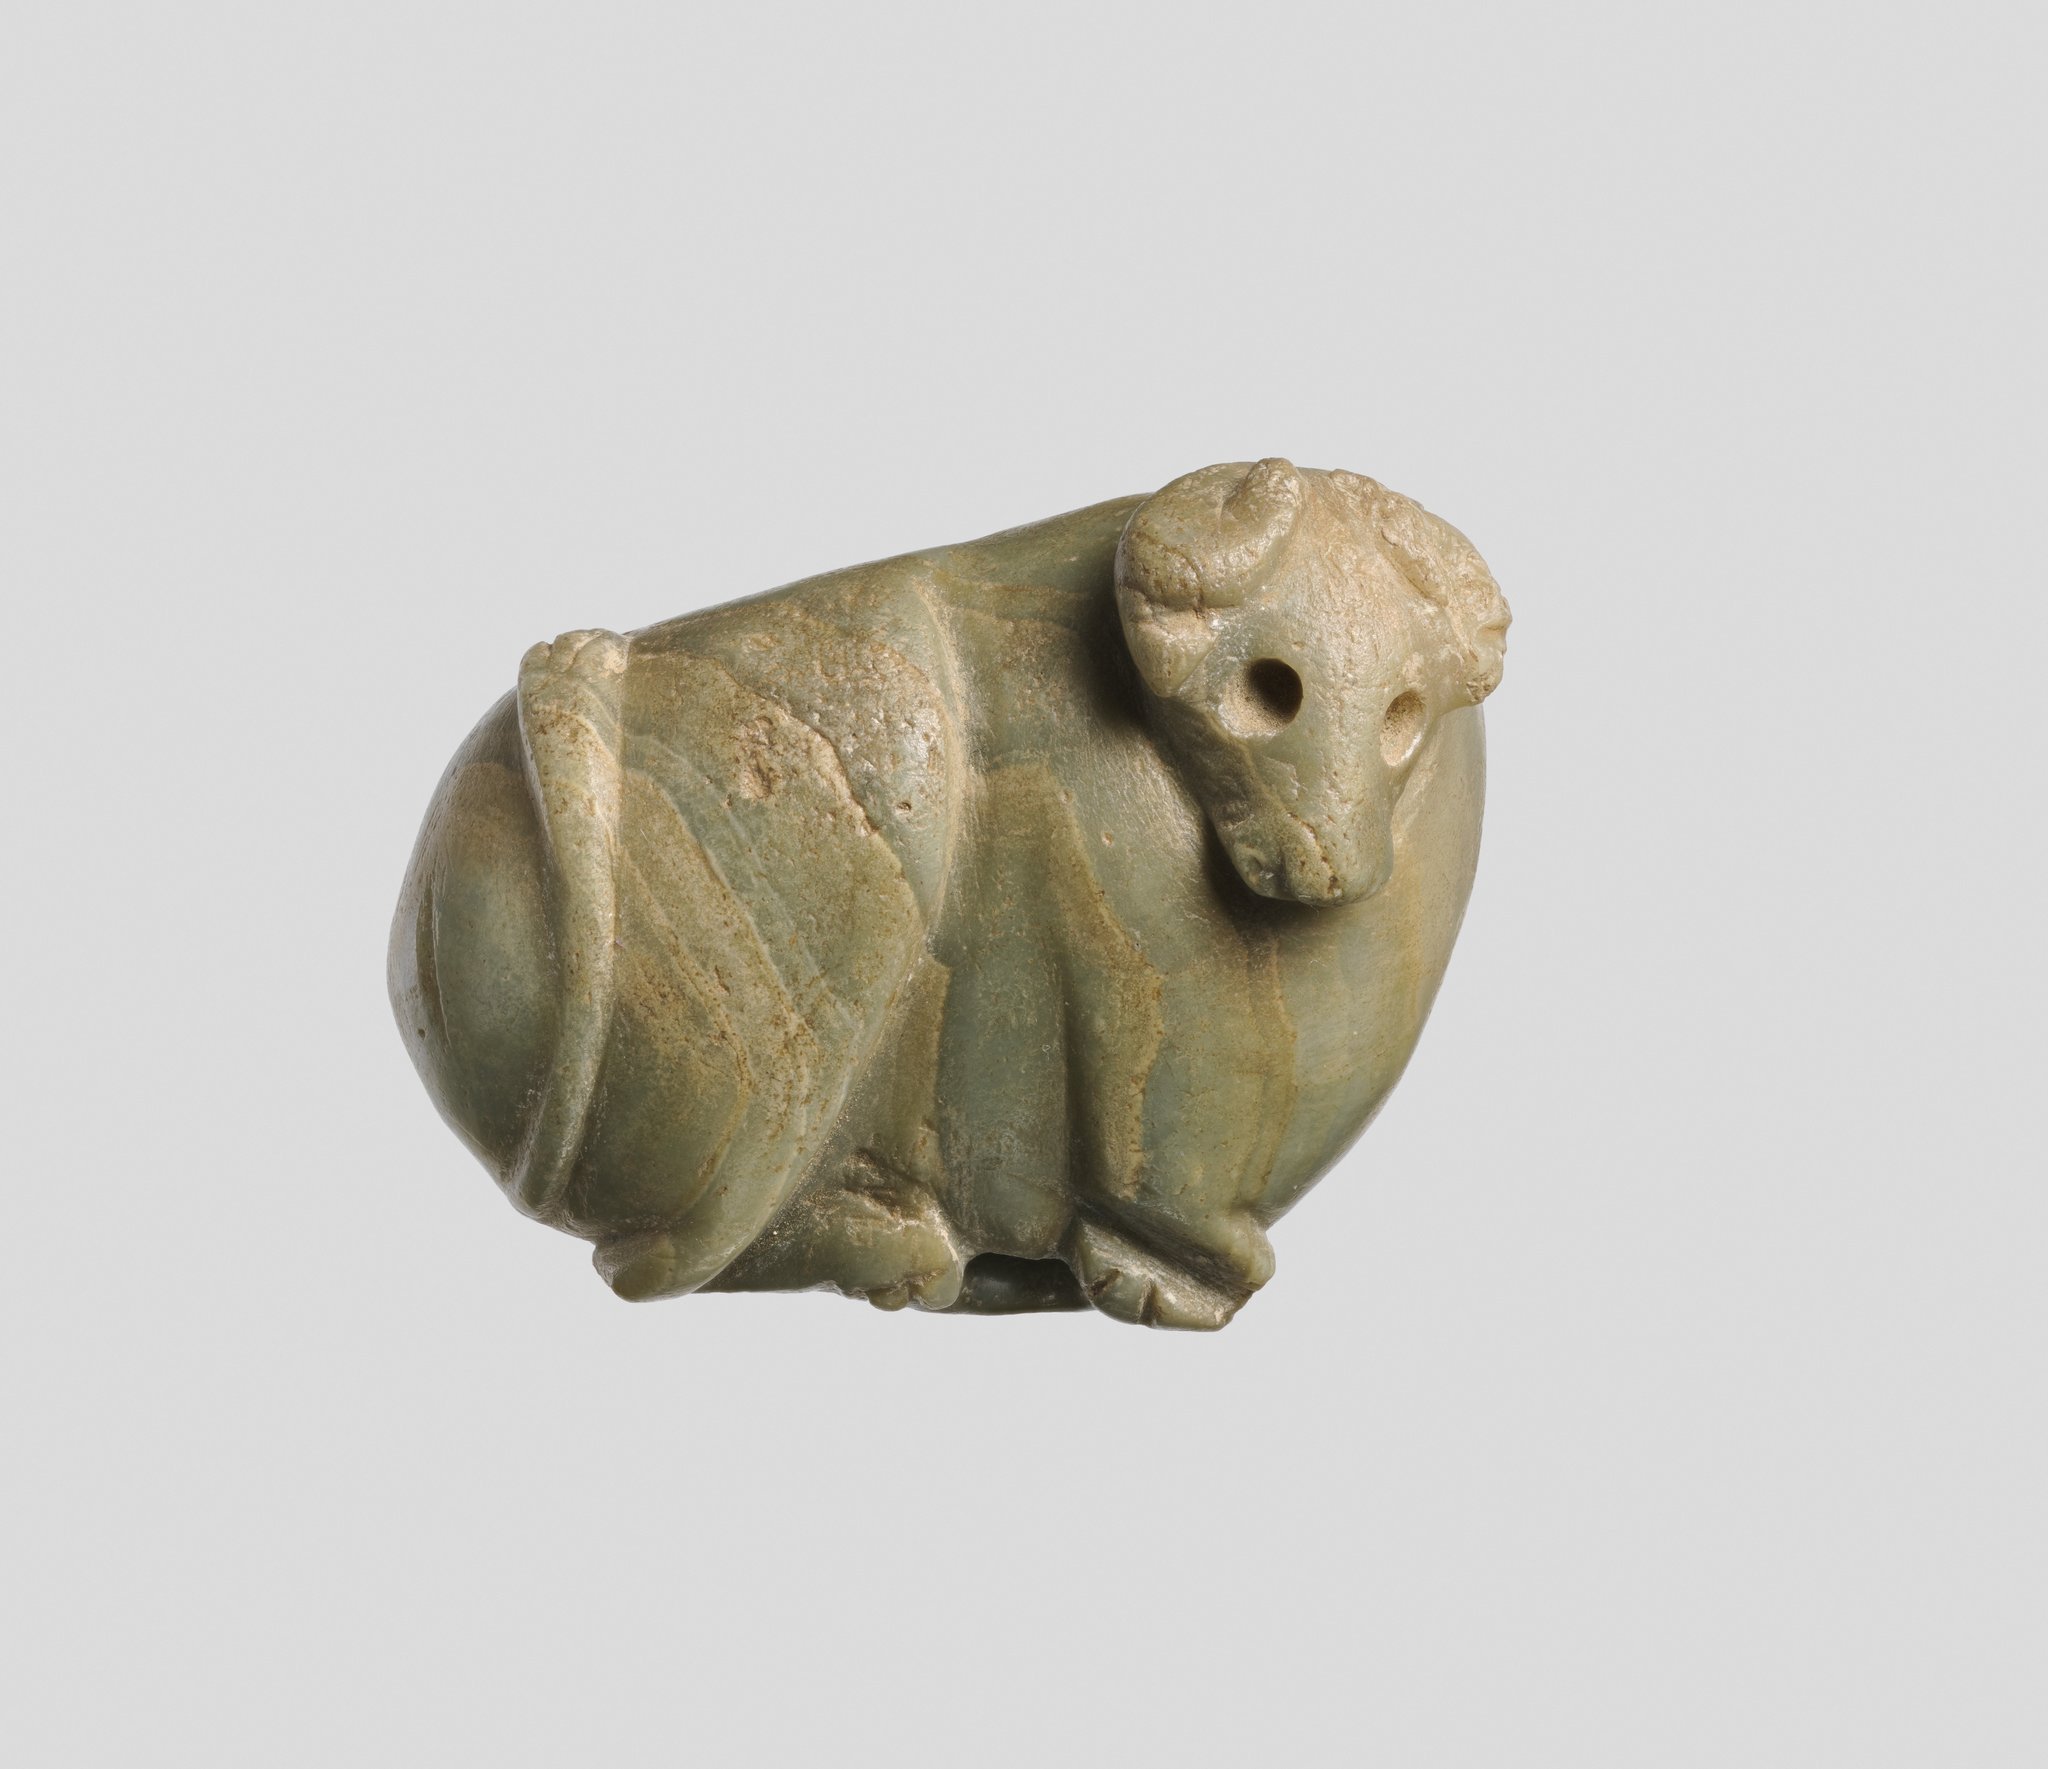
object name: stamp seal amulet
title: Seal amulet in the form of a reclining cow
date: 3300-2900 BCE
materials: onyx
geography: southern mesopotamia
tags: cows